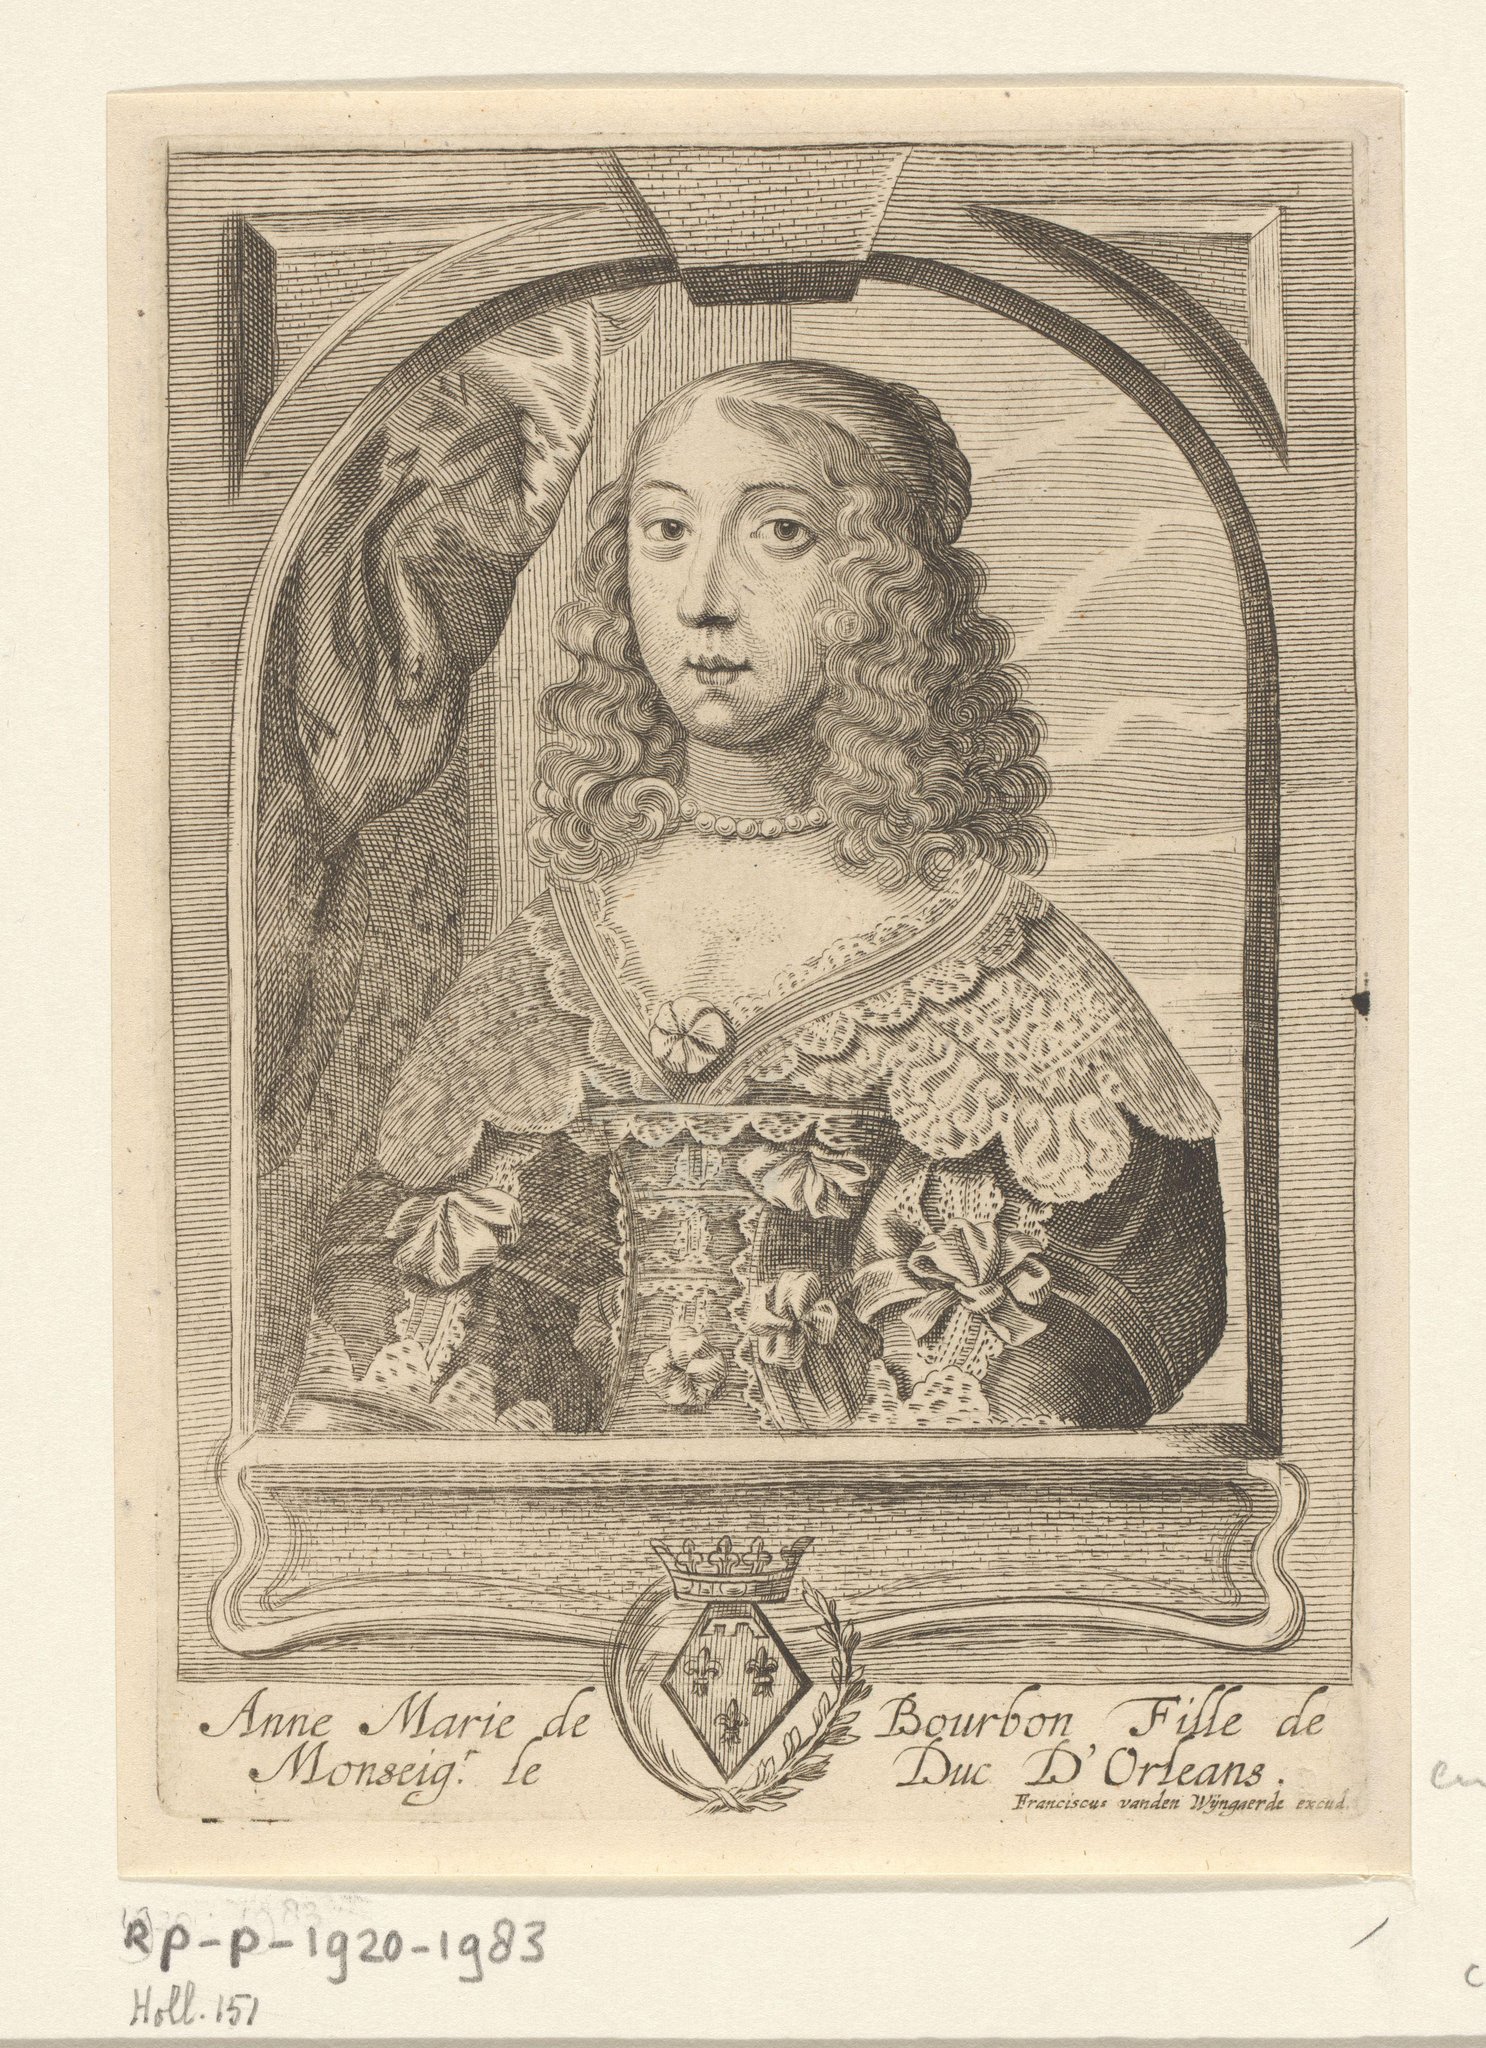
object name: print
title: Portret van Anna Marie Louise van Orléans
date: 1645-1679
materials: paper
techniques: engraving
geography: antwerp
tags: anne marie louise d' orléans (hertogin van montpensier), historical persons - bb - woman, pearl; pearl necklace, armorial bearing, heraldry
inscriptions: collector's mark: Lugt 2228